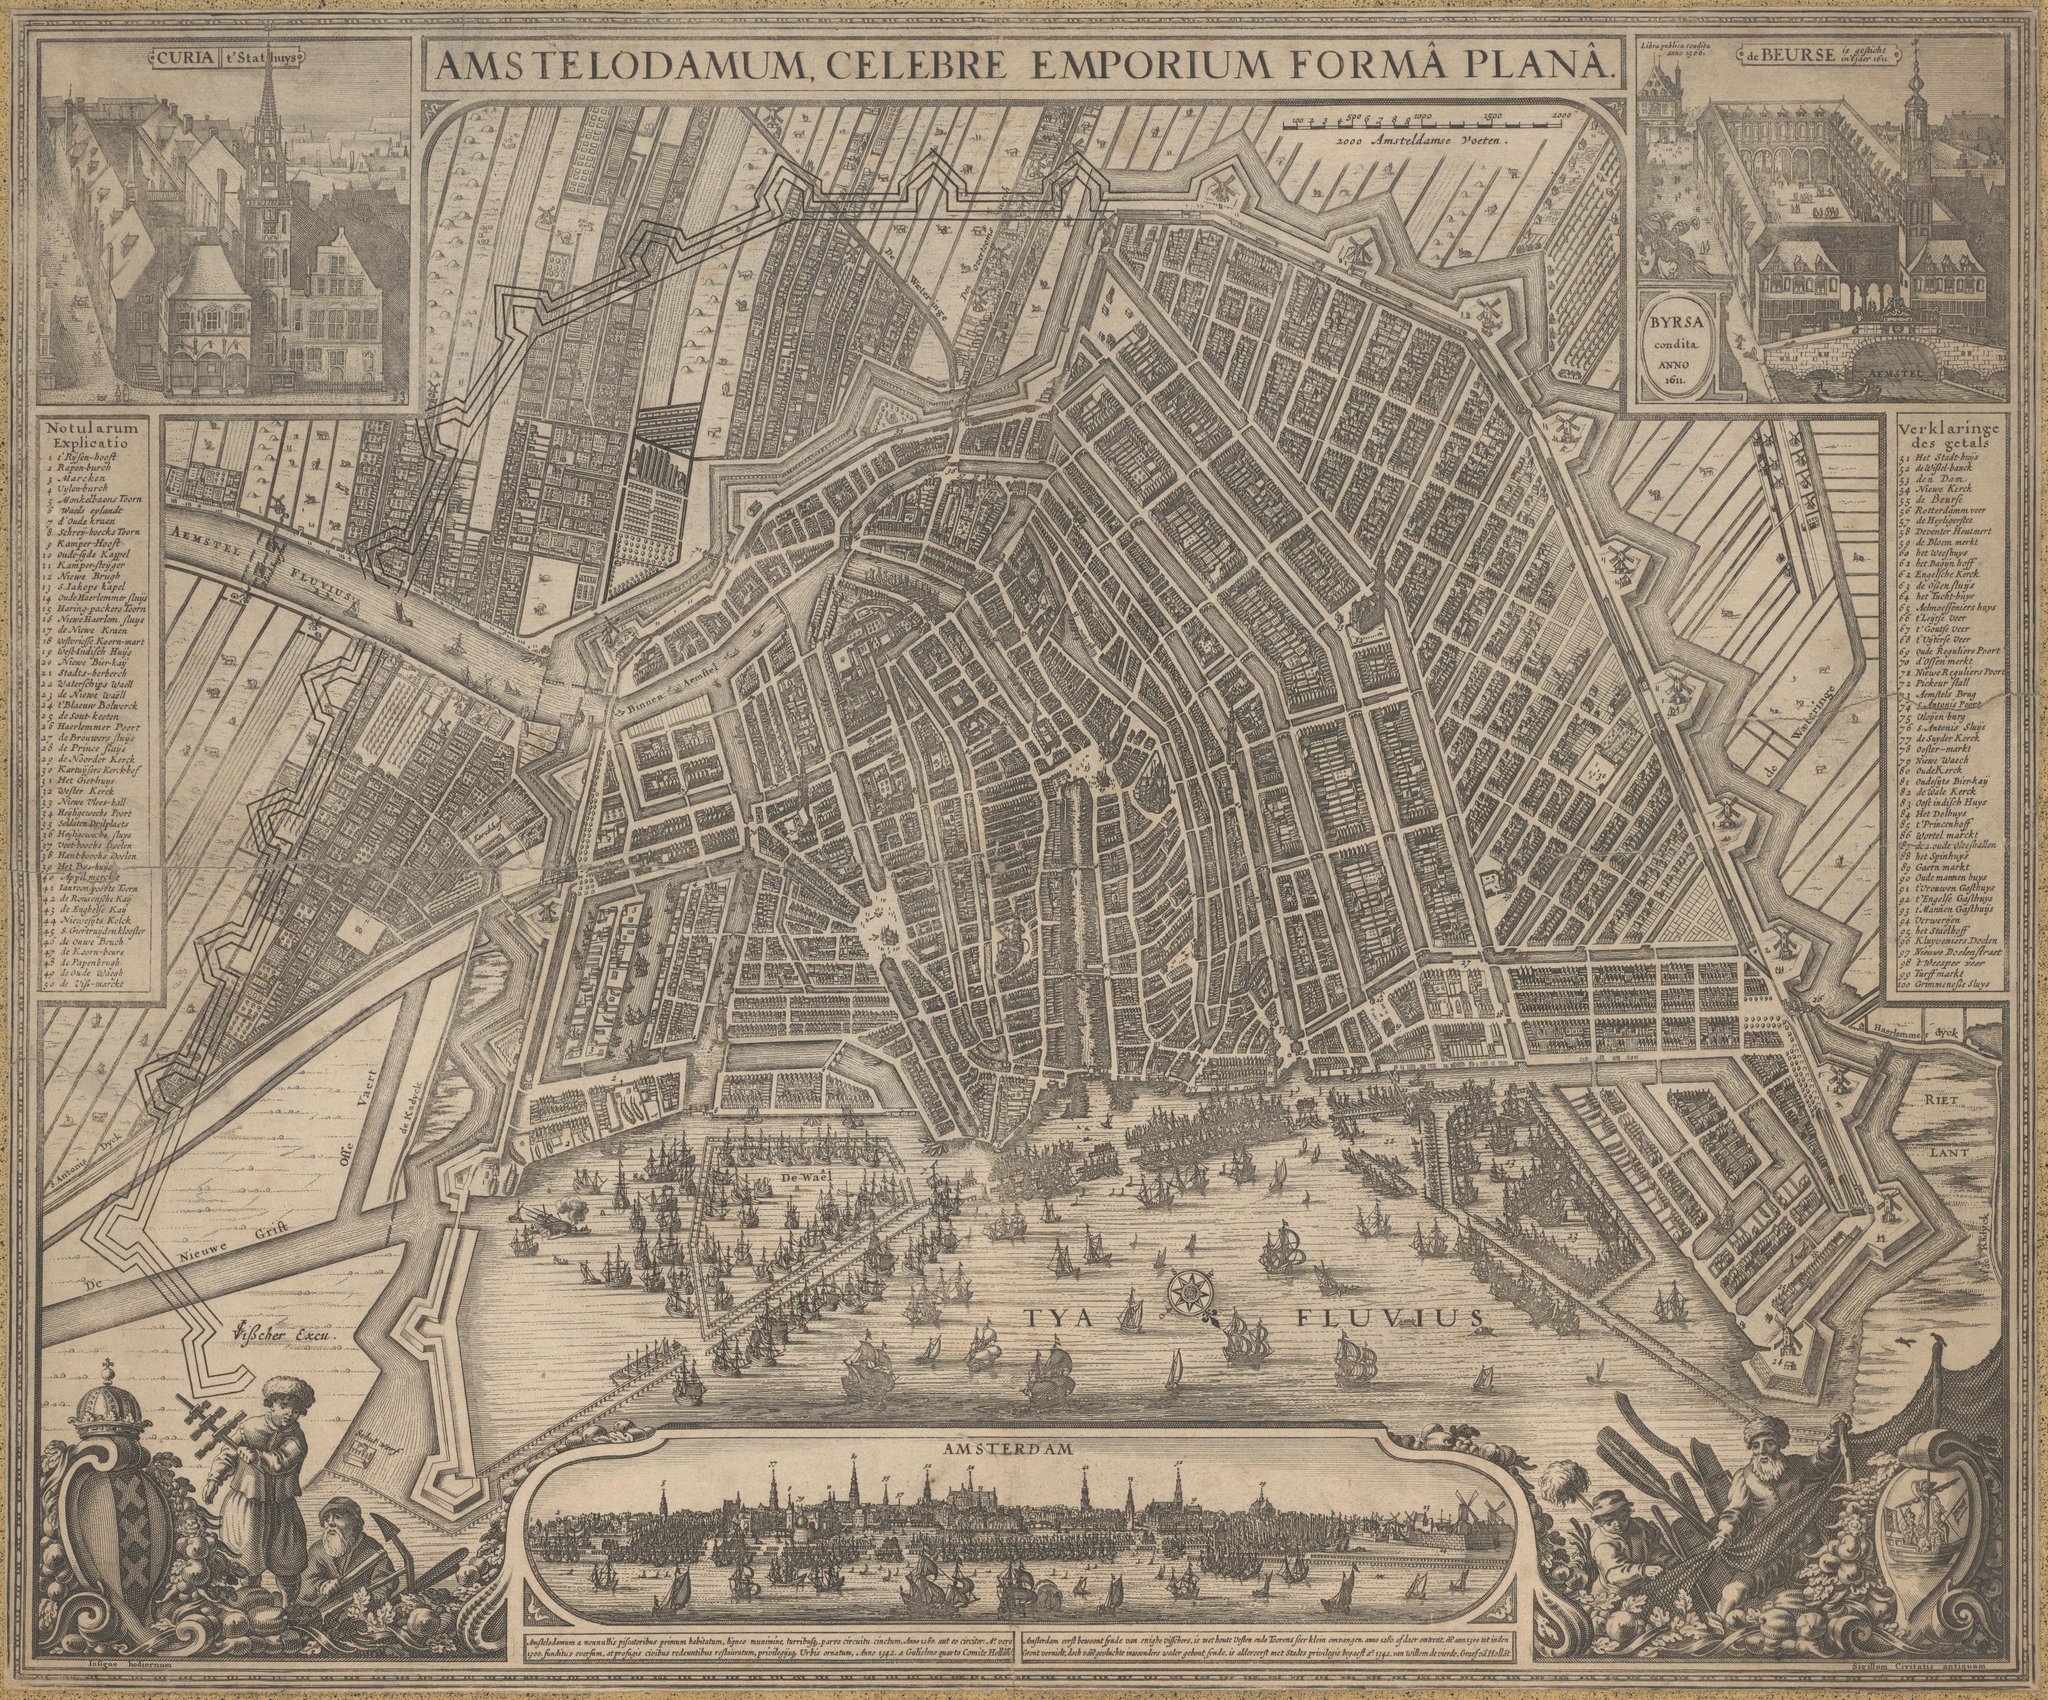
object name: map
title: Plattegrond van Amsterdam met stadsgezicht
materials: paper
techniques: engraving, etching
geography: northern netherlands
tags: coat of arms (as symbol of the state, etc.) (+ city; municipal), stock exchange, stock-market, townhall, seaman, parts of ship's exterior: anchor, maps of cities, prospect of city, town panorama, silhouette of city, amsterdam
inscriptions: collector's mark: Lugt 1641b